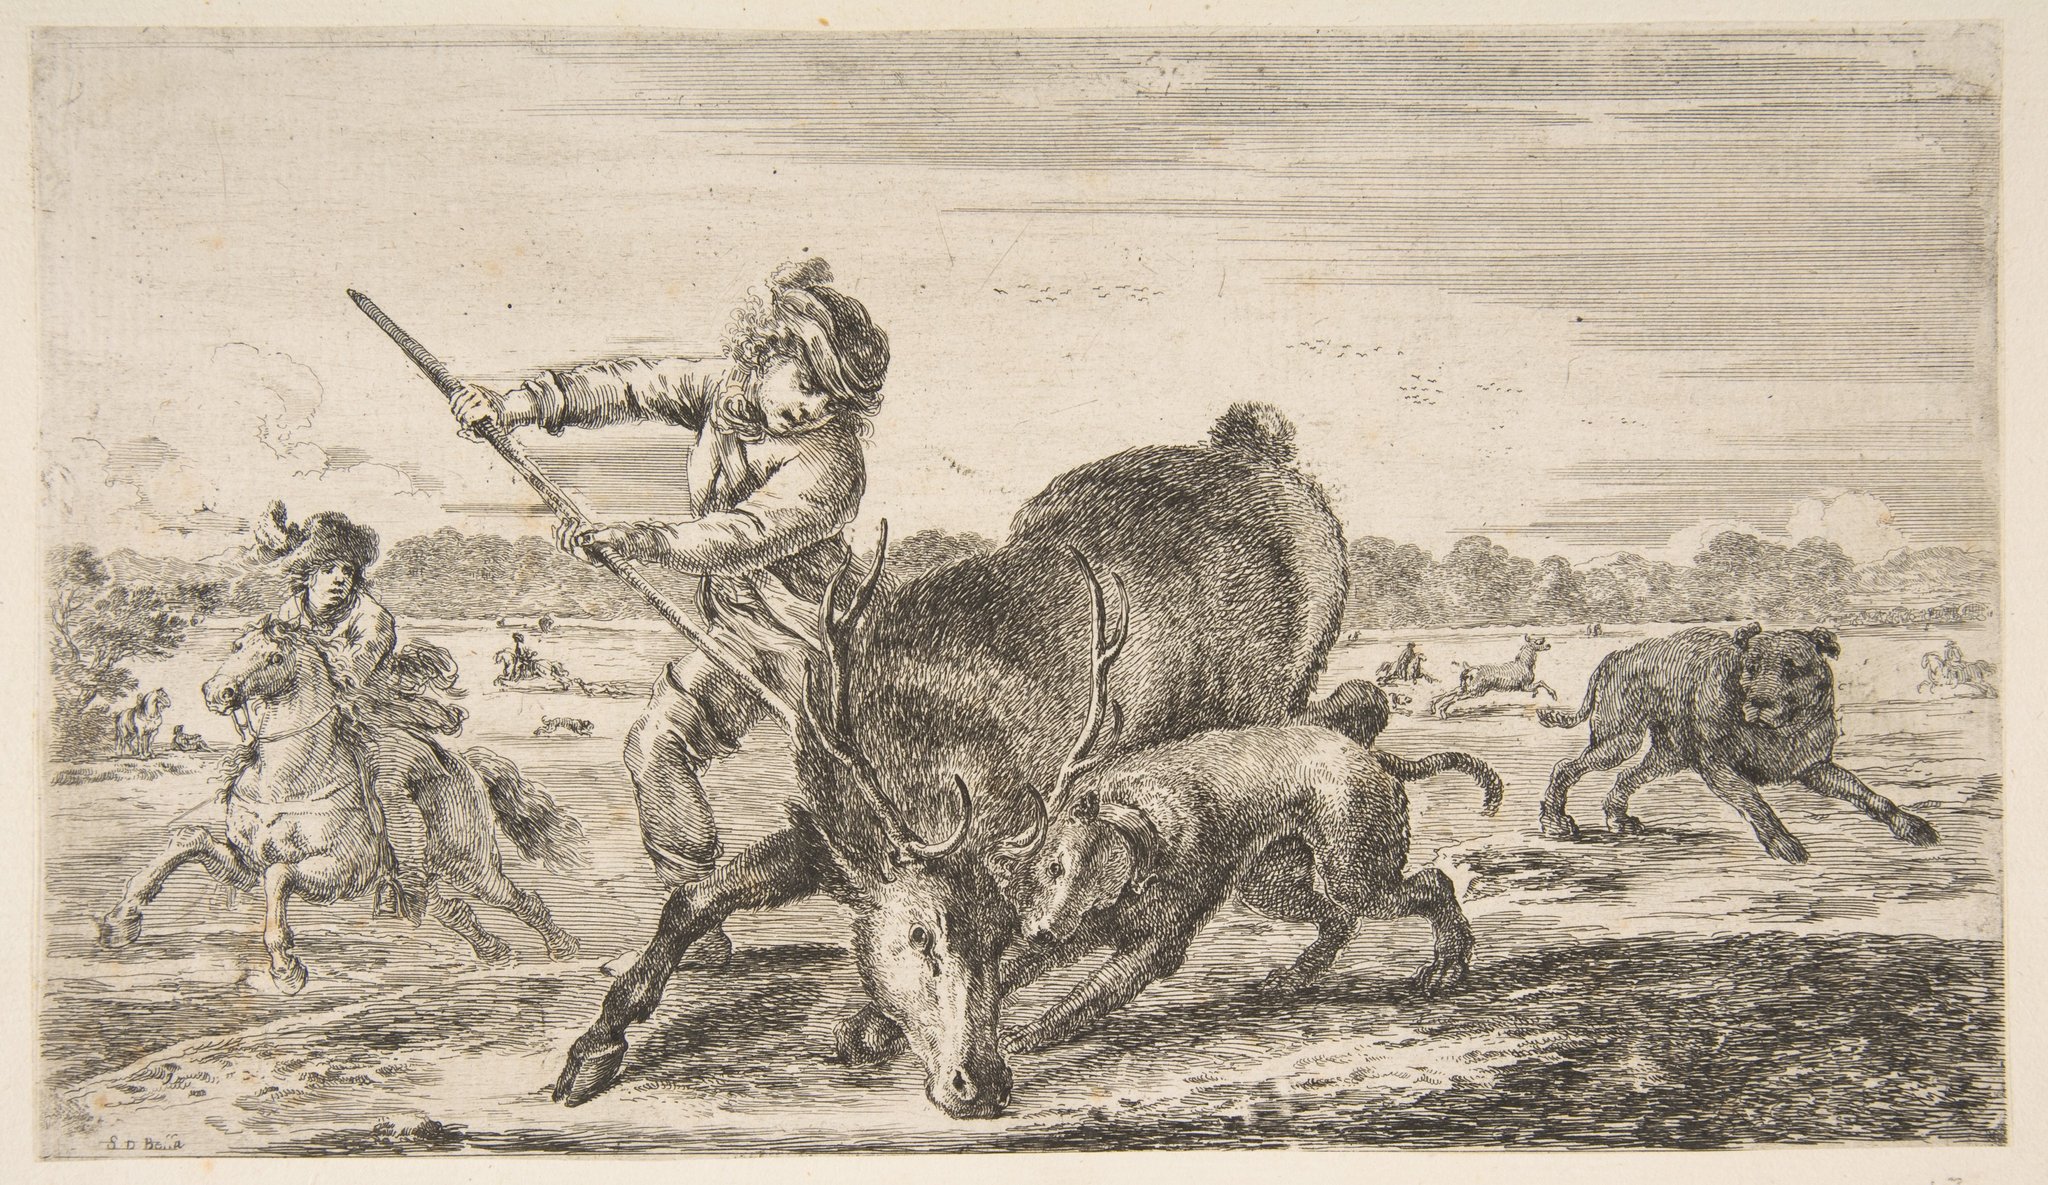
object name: print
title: Stag at bay, from "Animal hunts" (Chasses à différents animaux)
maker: stefano della bella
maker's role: artist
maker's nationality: italian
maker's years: 1610-1664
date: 1654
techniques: etching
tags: weapons,hunting,deer,dogs,horses